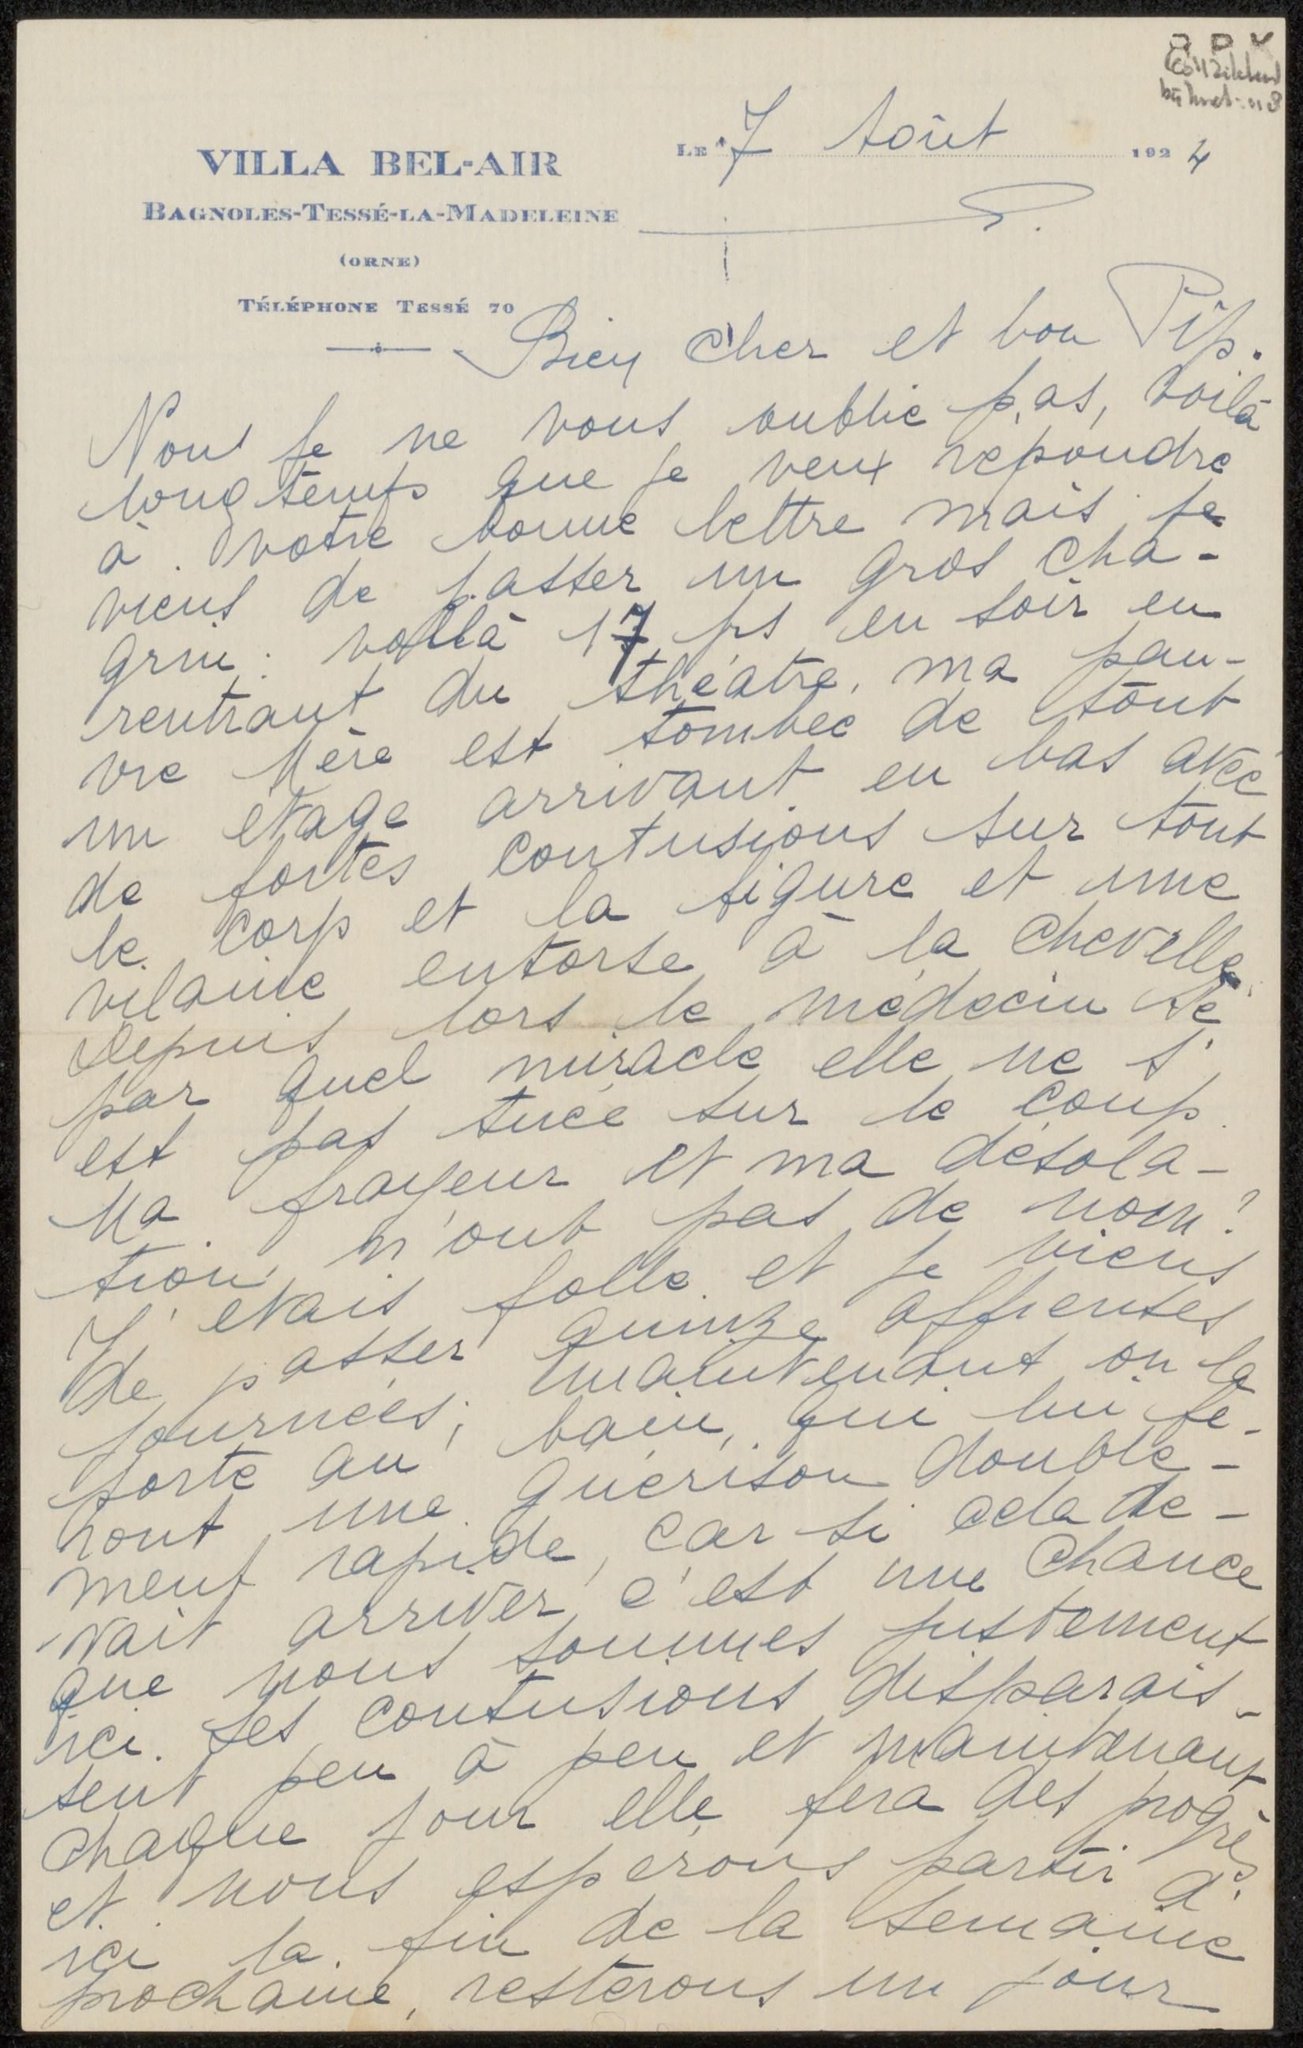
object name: letter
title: Brief aan Philip Zilcken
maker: rose imel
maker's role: draughtsman, painter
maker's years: 1901-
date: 1924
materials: ink, paper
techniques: pen, printing, writing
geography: tessé-la-madeleine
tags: painter, draughtsman, philip zilcken, the graphic arts, paris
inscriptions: collector's mark: ‘RPK’